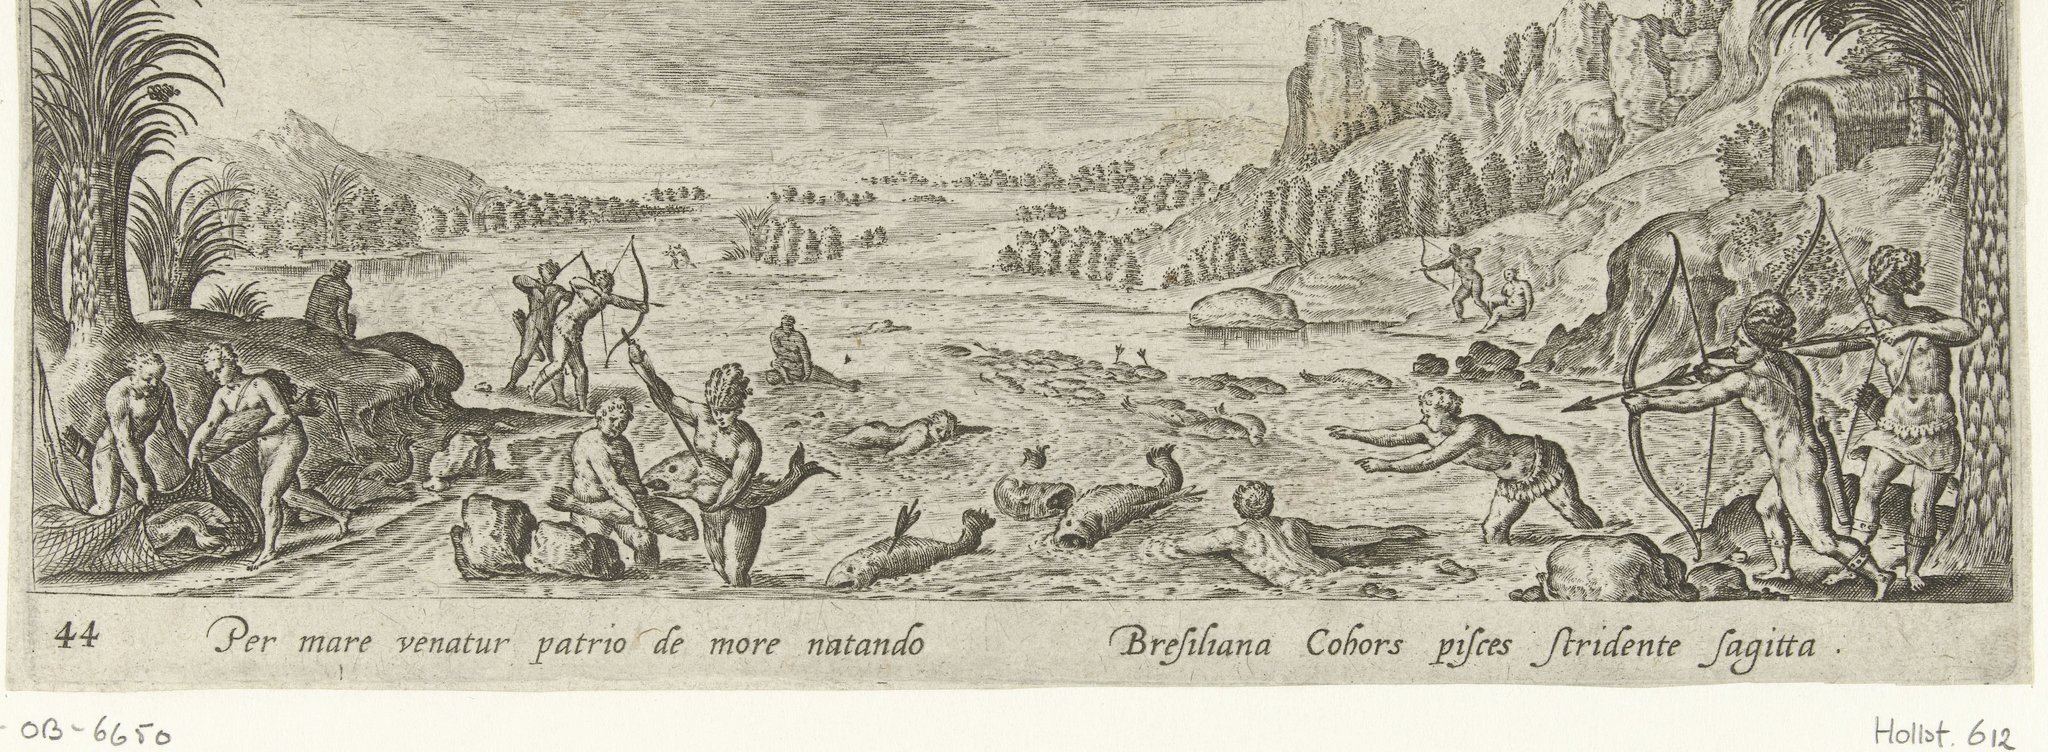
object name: print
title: Vissen met pijl en boog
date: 1582-1633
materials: paper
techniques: engraving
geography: antwerp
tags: native peoples of the americas, fishing (sports) (+ bow and arrow)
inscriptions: collector's mark: Lugt 2228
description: Oorspronkelijke Amerikanen vangen vis in een rivier door ze van op de oever met pijl-en-boog neer te schieten. De prent heeft een Latijns onderschrift en maakt deel uit van een serie van 54 prenten.